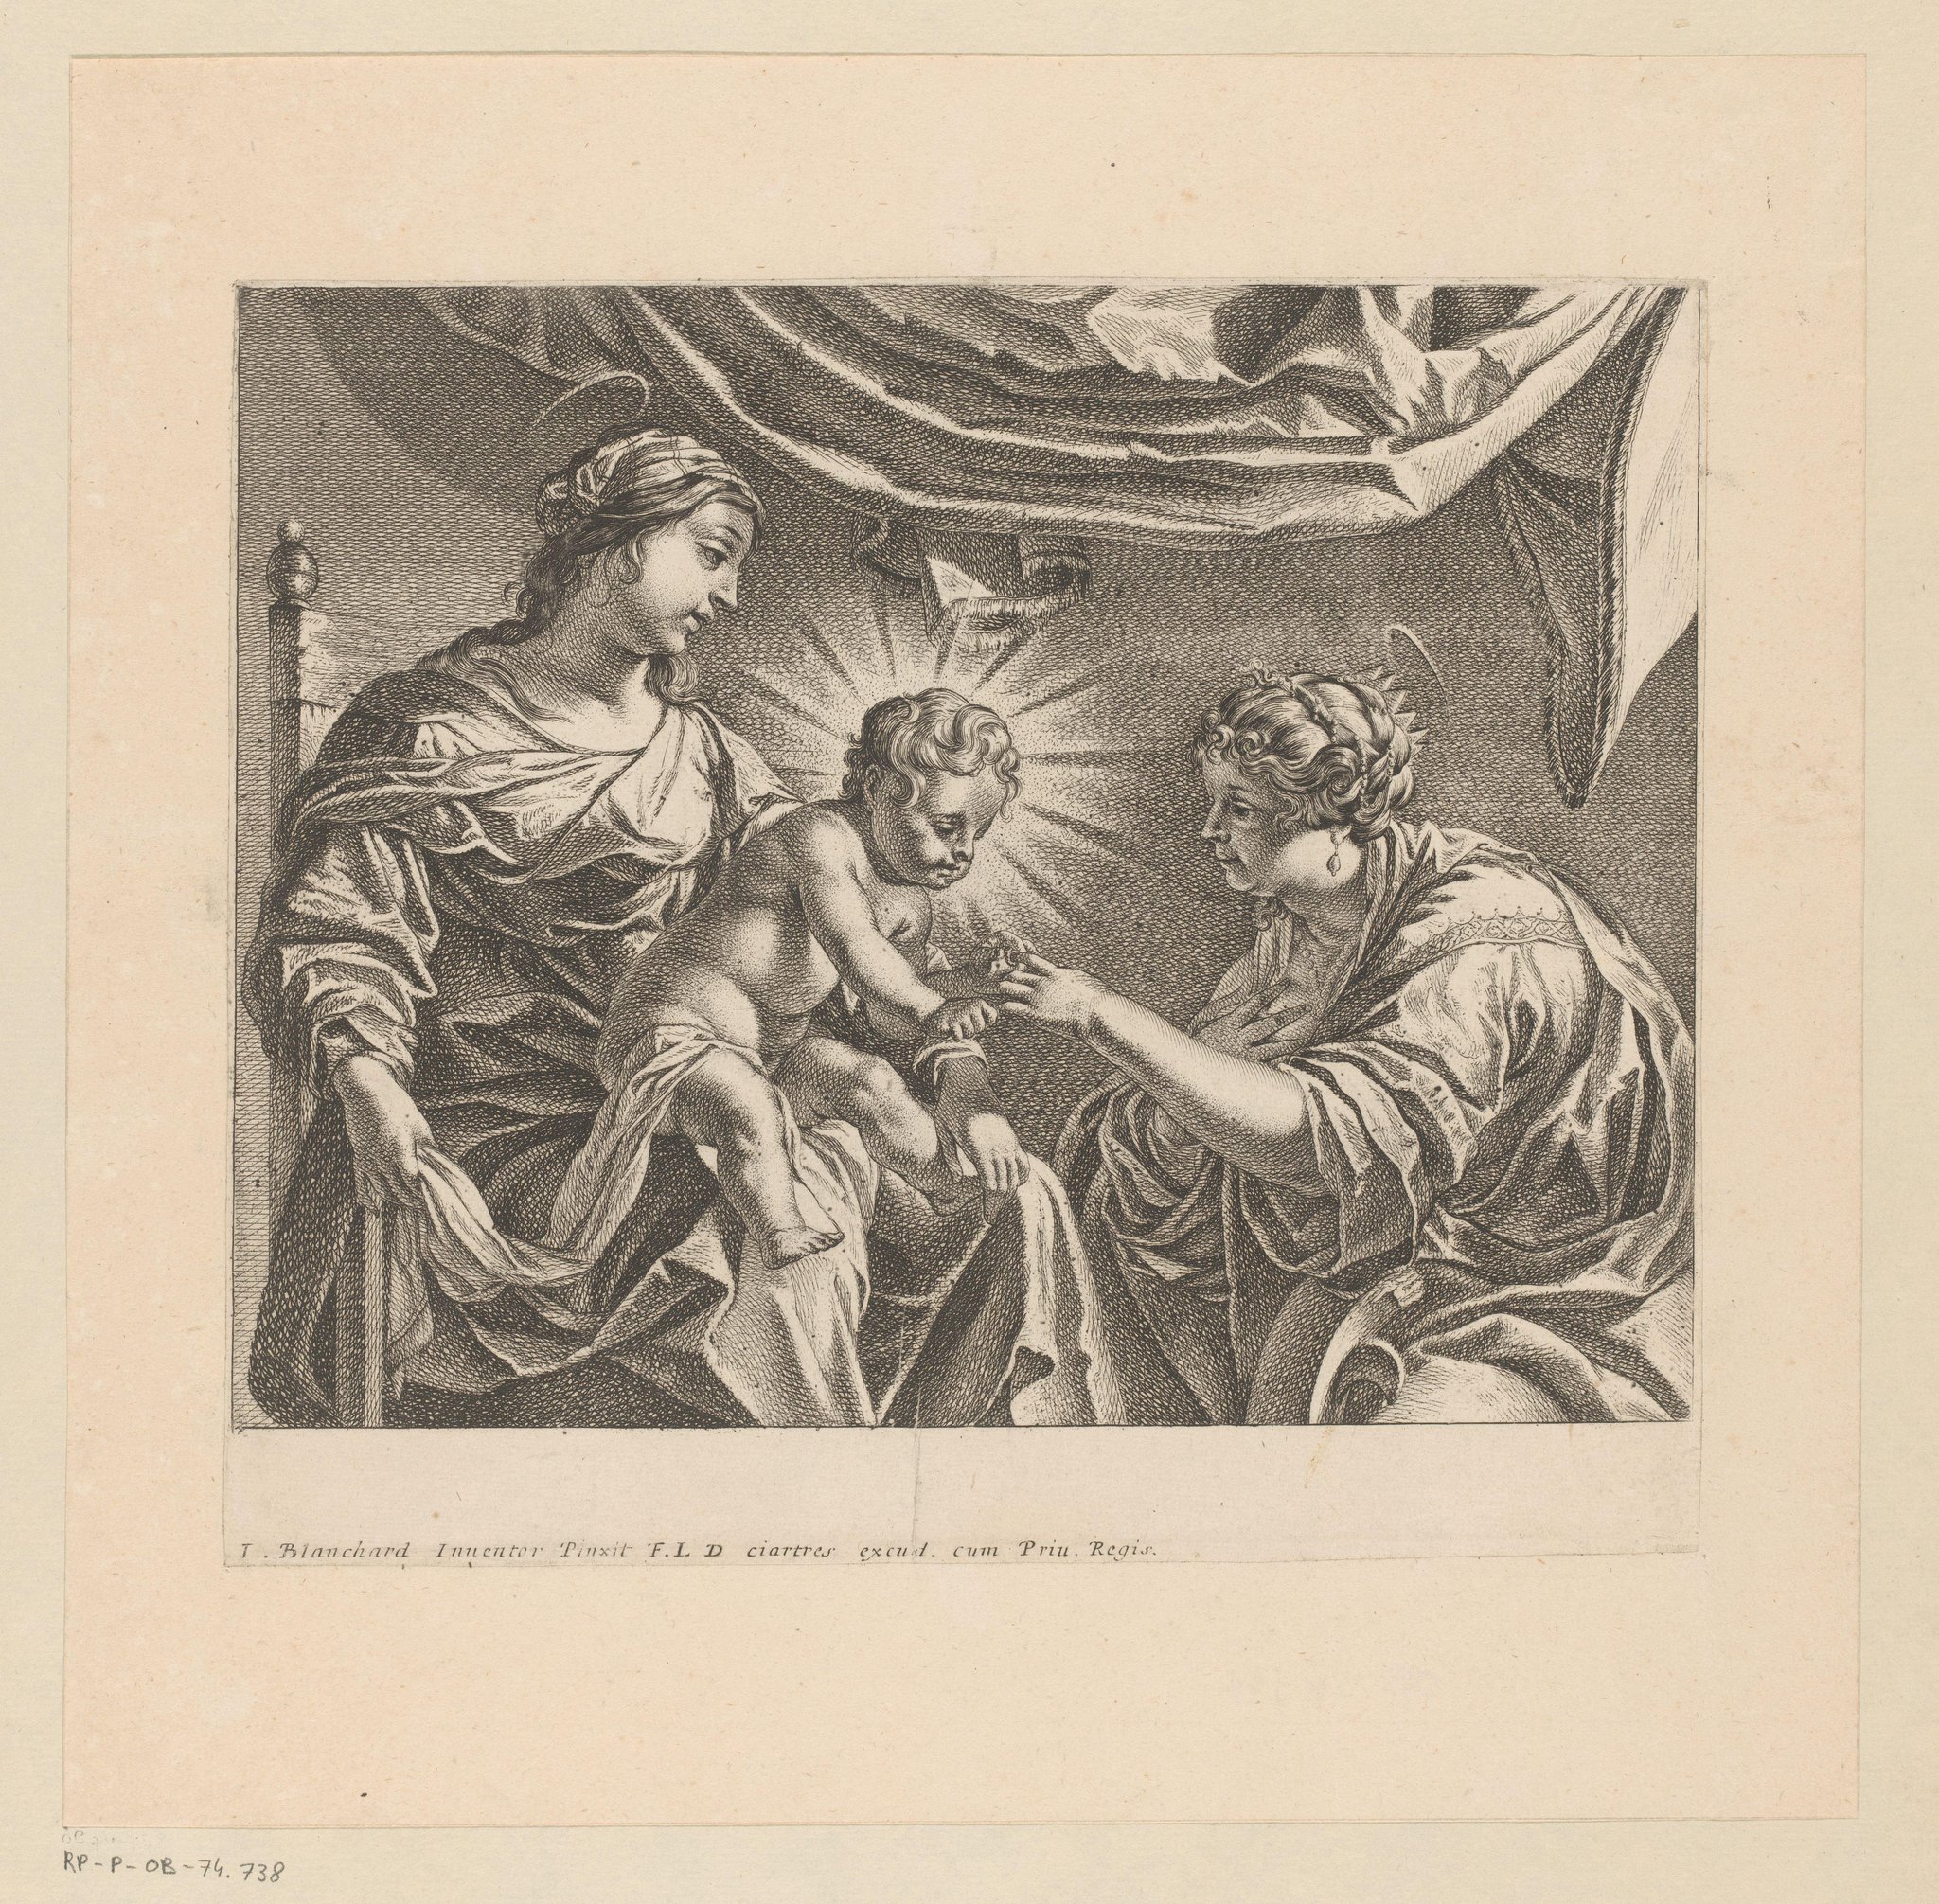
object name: print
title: Mystieke huwelijk van H. Catherina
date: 1621-1647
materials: paper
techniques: engraving, etching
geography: france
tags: the mystic marriage of st. catherine of alexandria with the infant christ: the christ-child puts a ring on her finger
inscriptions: collector's mark: Lugt 240